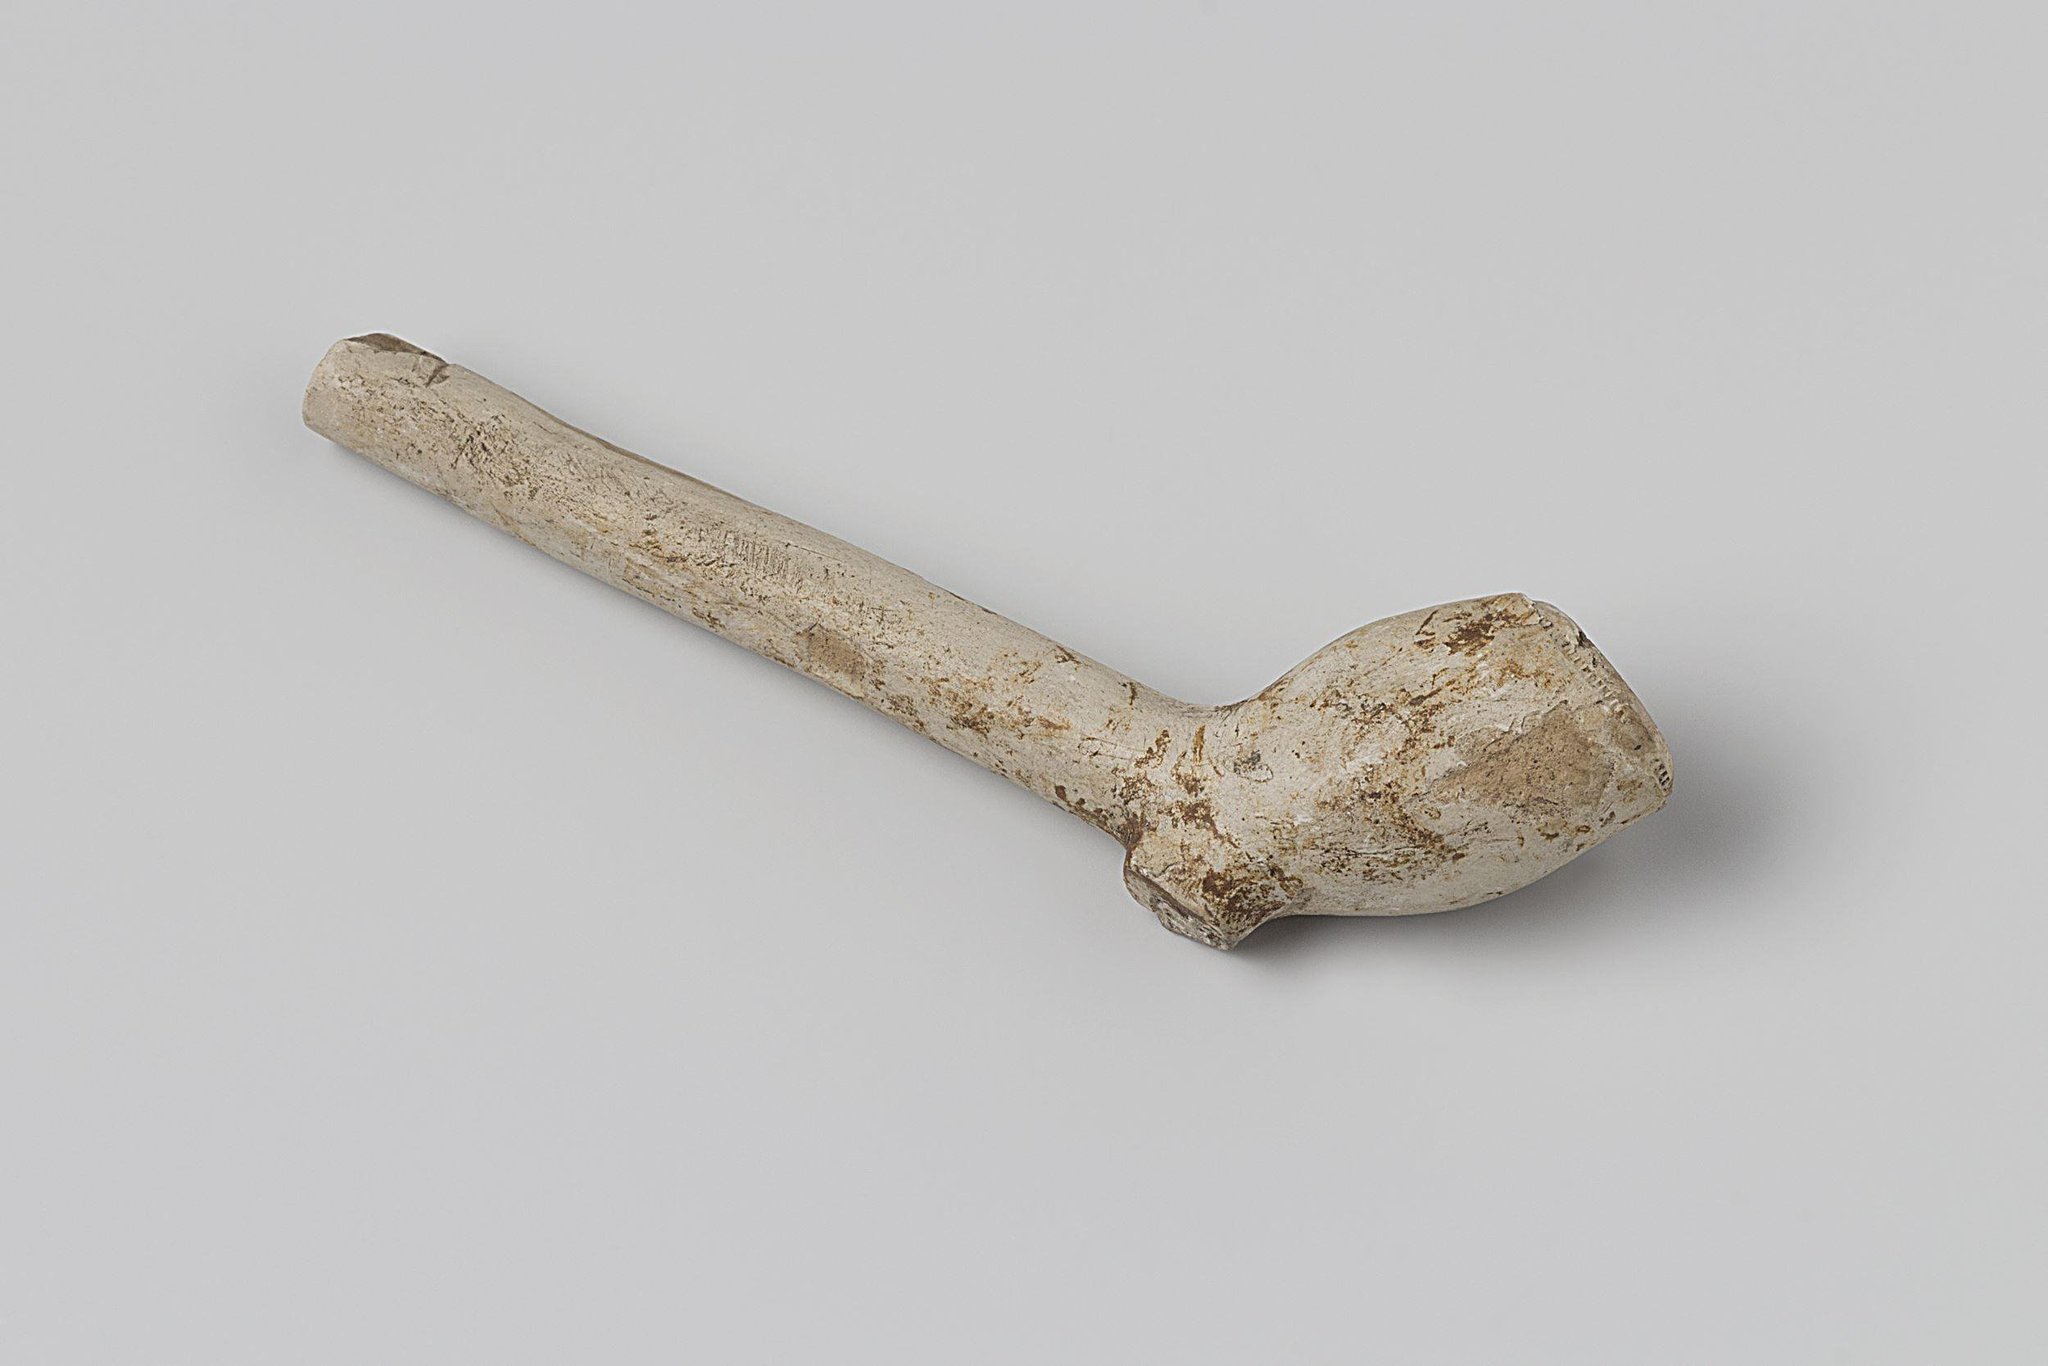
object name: tabakspijp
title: Fragment van een tabakspijp.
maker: Anonymous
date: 1600-1699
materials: clay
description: Een fragment van een kleine witte tabakspijp, waarop H.